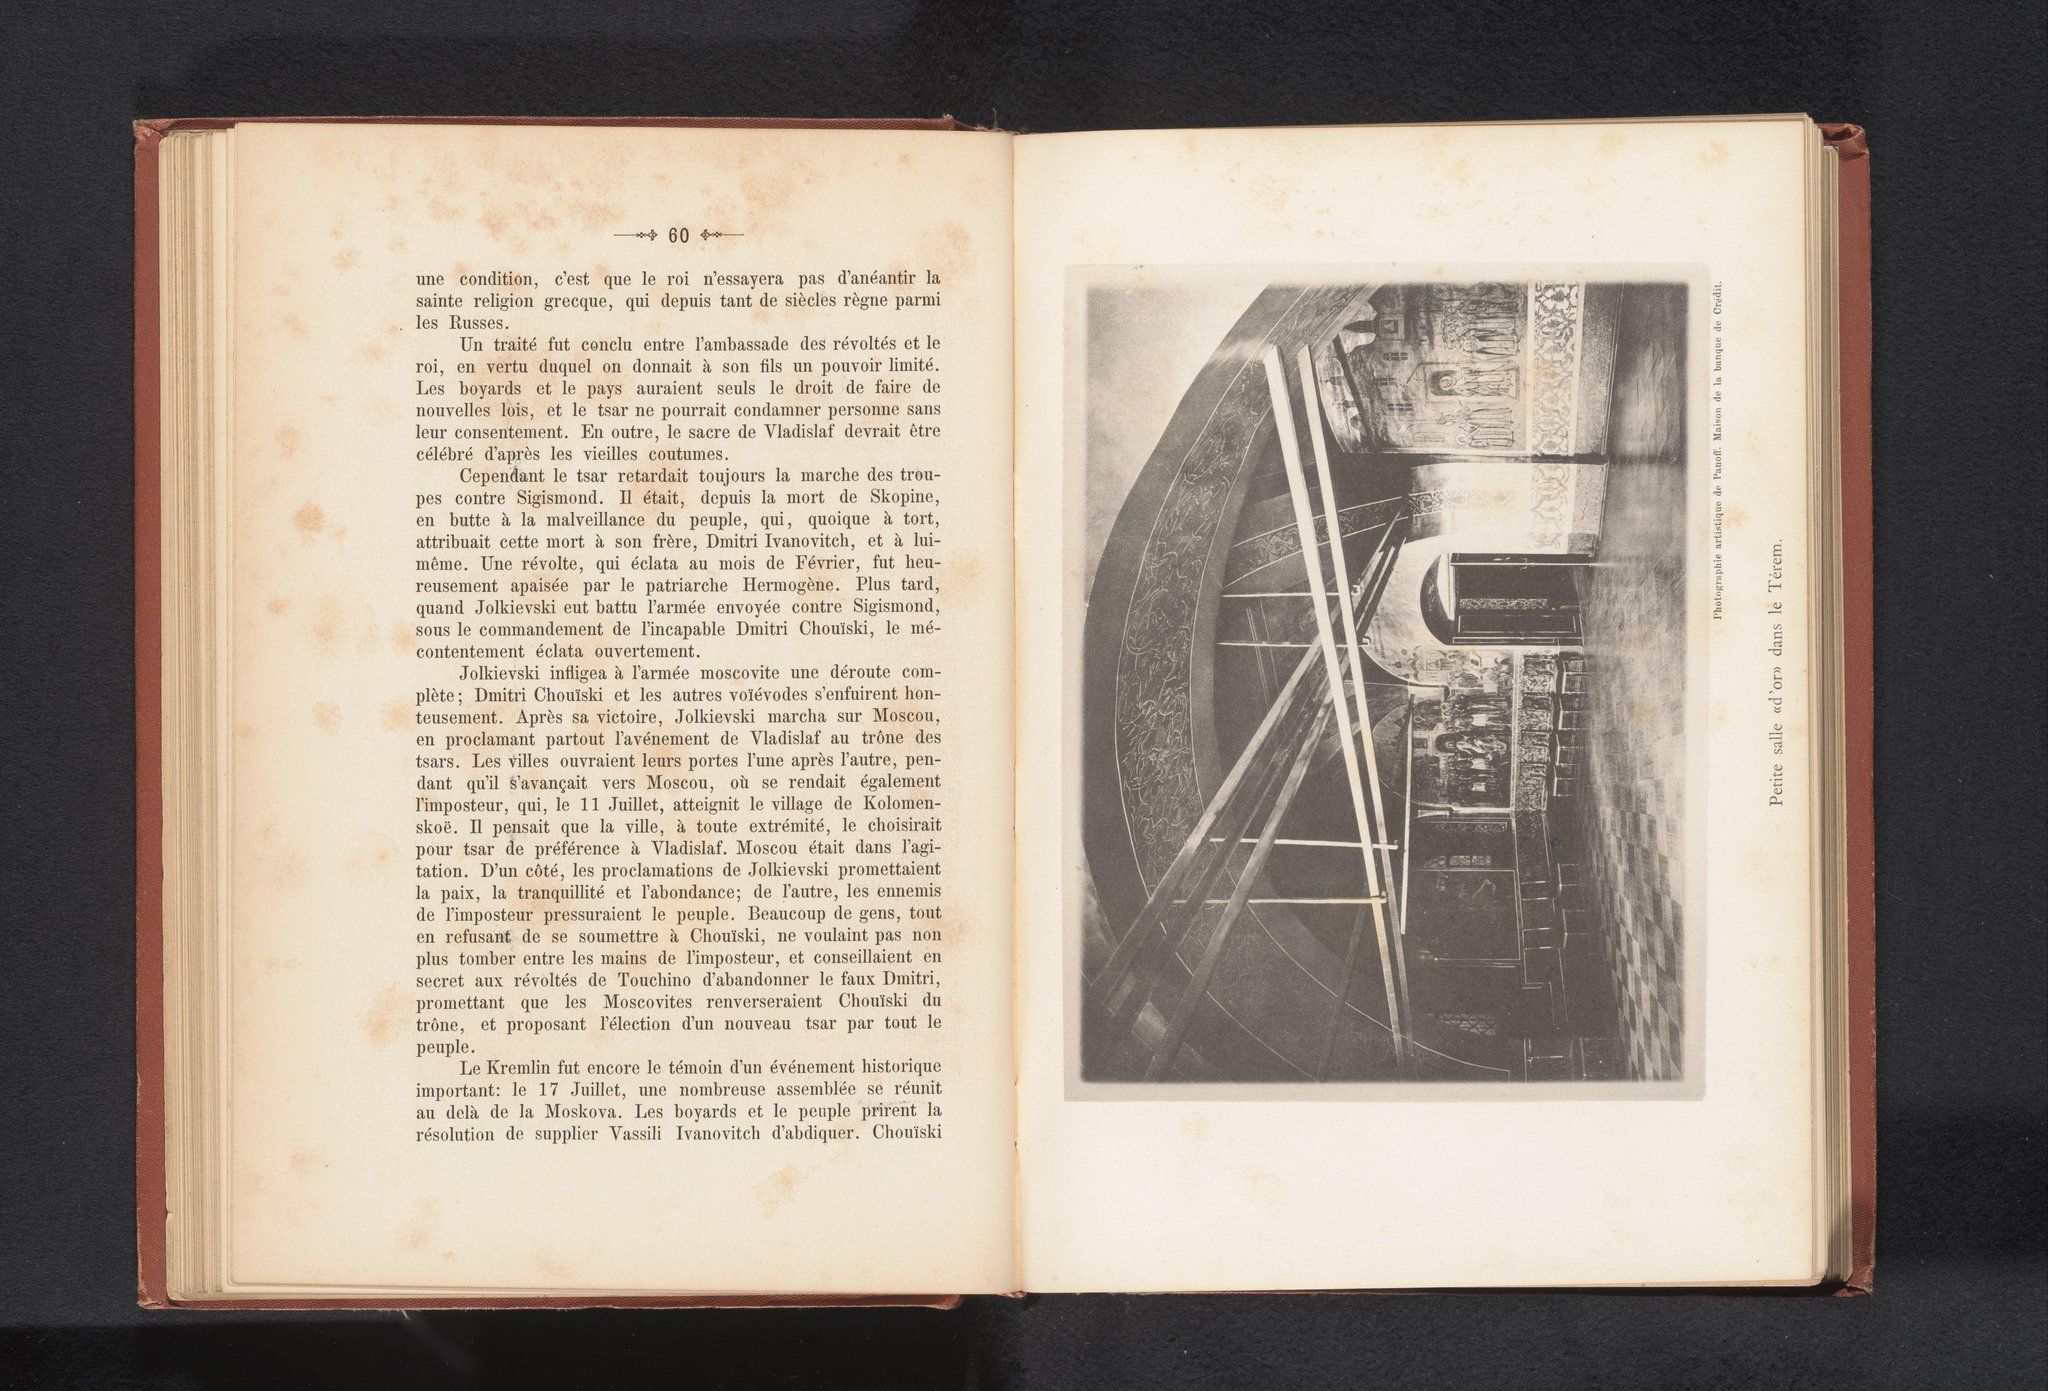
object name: page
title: Interieur van een zaal van het Terempaleis in het Kremlin van Moskou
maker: Anonymous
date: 1873-1883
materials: paper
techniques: photograph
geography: moscow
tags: palace, wall-covering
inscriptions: name: ‘Photographie artistique de Panoff. Maison de la banque de Crédit.’